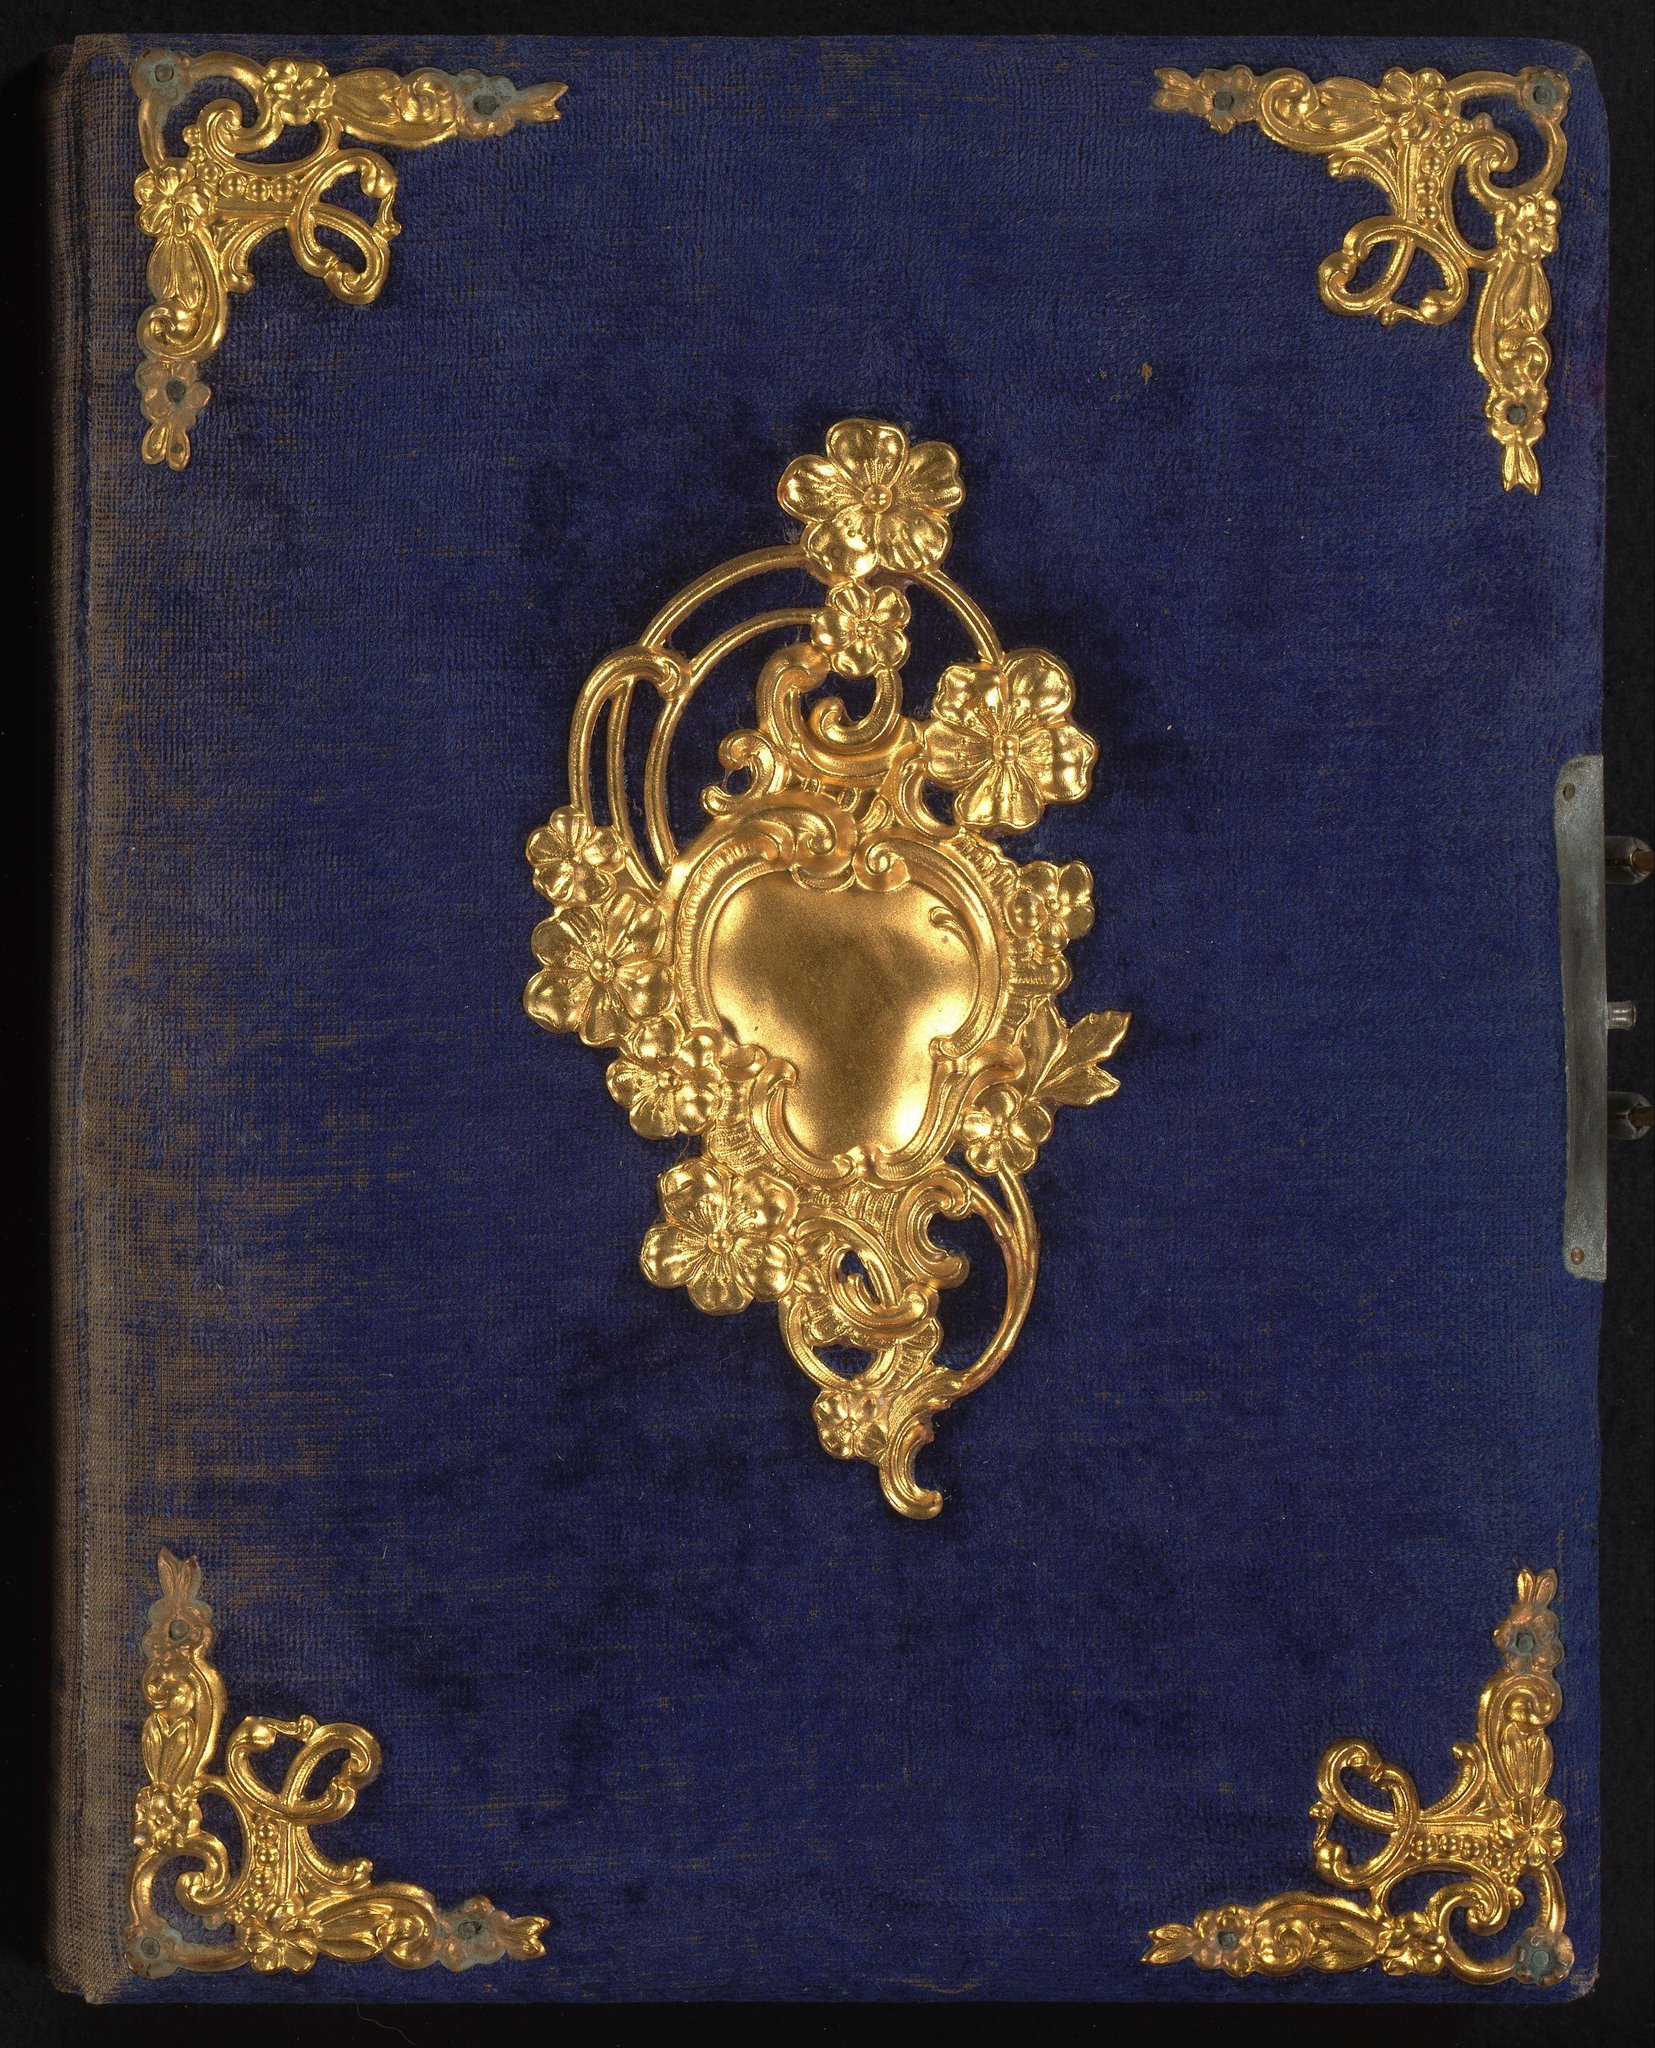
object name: slip in album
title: Fotoalbum (leeg)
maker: Anonymous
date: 1860-1900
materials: cardboard, metal, paper, textile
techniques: color on snow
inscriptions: collector's mark: ‘DIENST/ VERSPREIDE/ RIJKSKOLLEKTIES/ (...) A 704’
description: Fotoalbum met 24 pagina's met op iedere pagina ofwel een met gouden lijnen omkaderde passe-partout voor een kabinetfoto, ofwel vier met gouden lijnen omkaderde passe-partouts voor cartes-de-visite. In totaal is er in het album ruimte voor 8 kabinetfoto's en 64 cartes-de-visite.